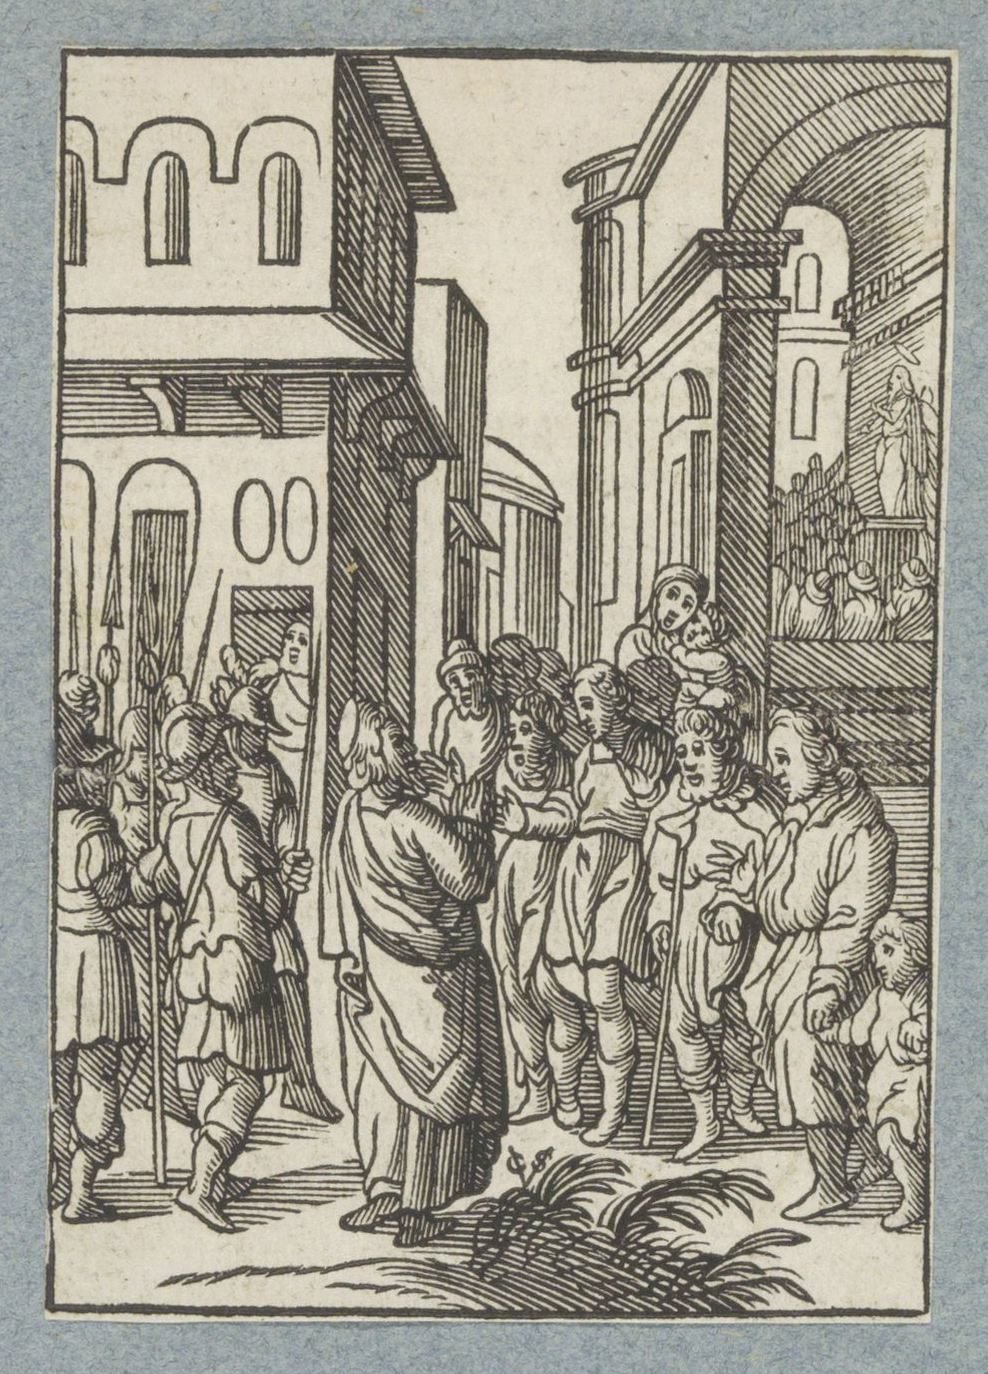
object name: book illustration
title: Paulus verkondigt de leer van Christus te Rome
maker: pieter jacobsz. paets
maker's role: publisher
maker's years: 1587-1667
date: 1629-1646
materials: paper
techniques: letterpress printing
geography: antwerp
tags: paul preaches and tells his story to jews while guarded by soldiers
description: De prent is afkomstig uit een van de uitgaven van P.J. Paets uit Amsterdam. De prent wordt mogelijk al gebruikt in: Der Zielen Lust-hof. Leuven, I.Jacbosz voor P.J. Paets [= Amsterdam, P.J. Paets], 1629. Ze komt in ieder geval voor in: Het Nieuwe Testament ons Salichmaeckers Jesu Christi. Amsterdam, P.J. Paets, 1646. De voorstelling is gekopieerd naar een prent van Philips Galle naar Jan van der Straet, onderdeel van de serie getiteld Acta Apostolorum.